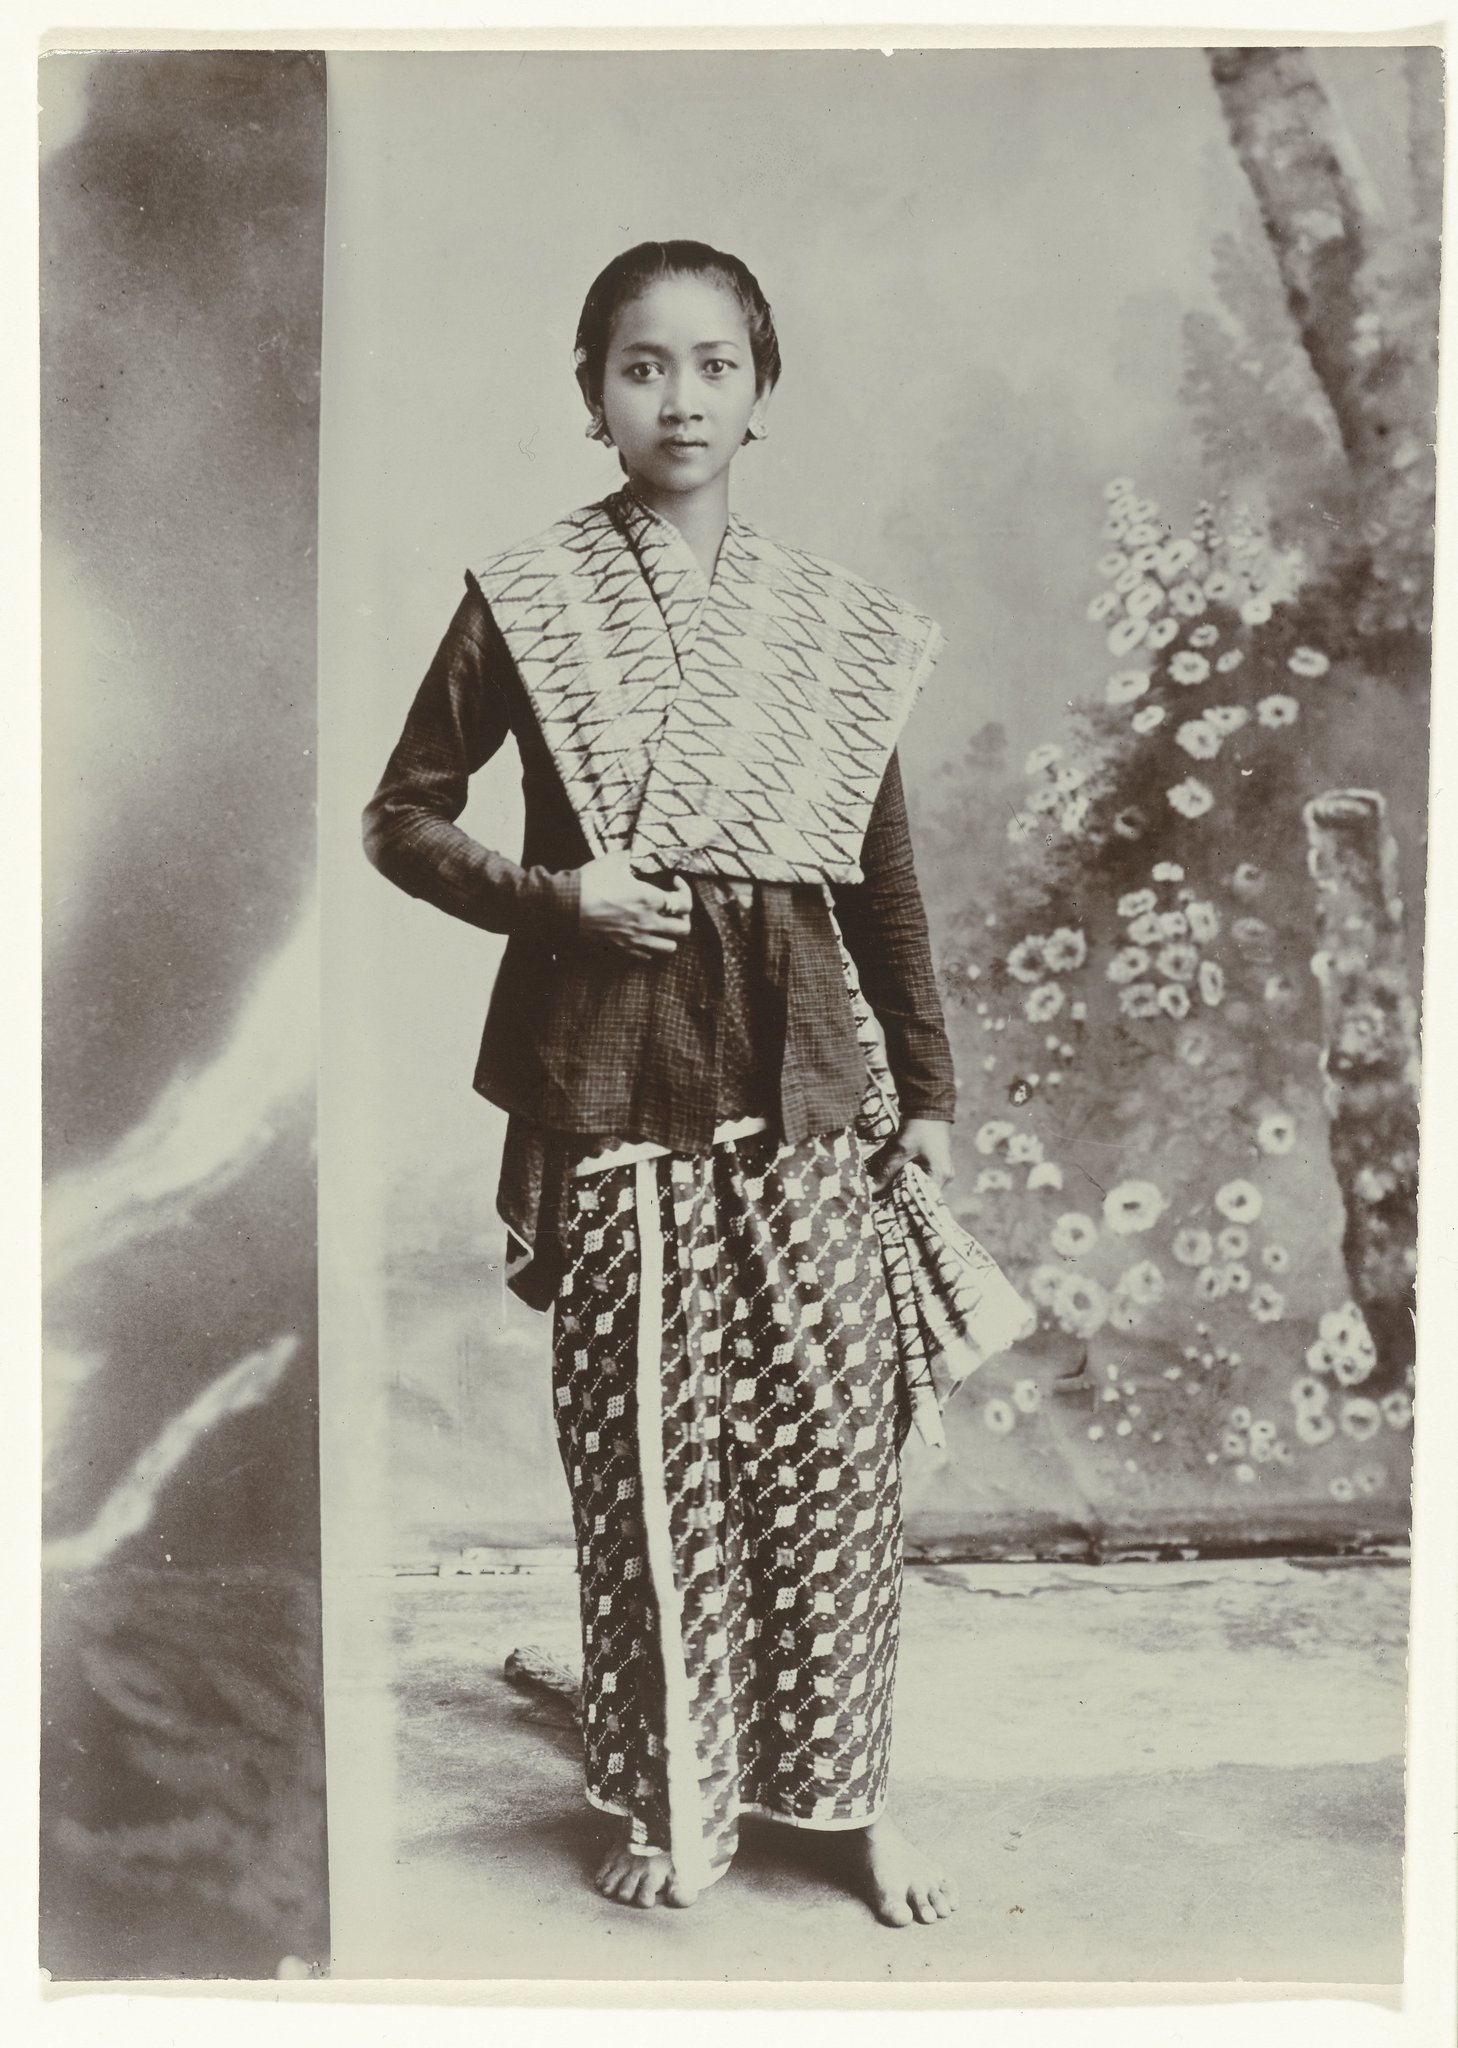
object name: photograph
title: Studioportret van een jonge Javaanse vrouw in een sarong met batik motief en een overhemd met ruitjes patroon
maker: kassian céphas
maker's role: fotograaf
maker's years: 1845-1912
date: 1867-1910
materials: cardboard, paper, photographic support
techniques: albumen print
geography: java